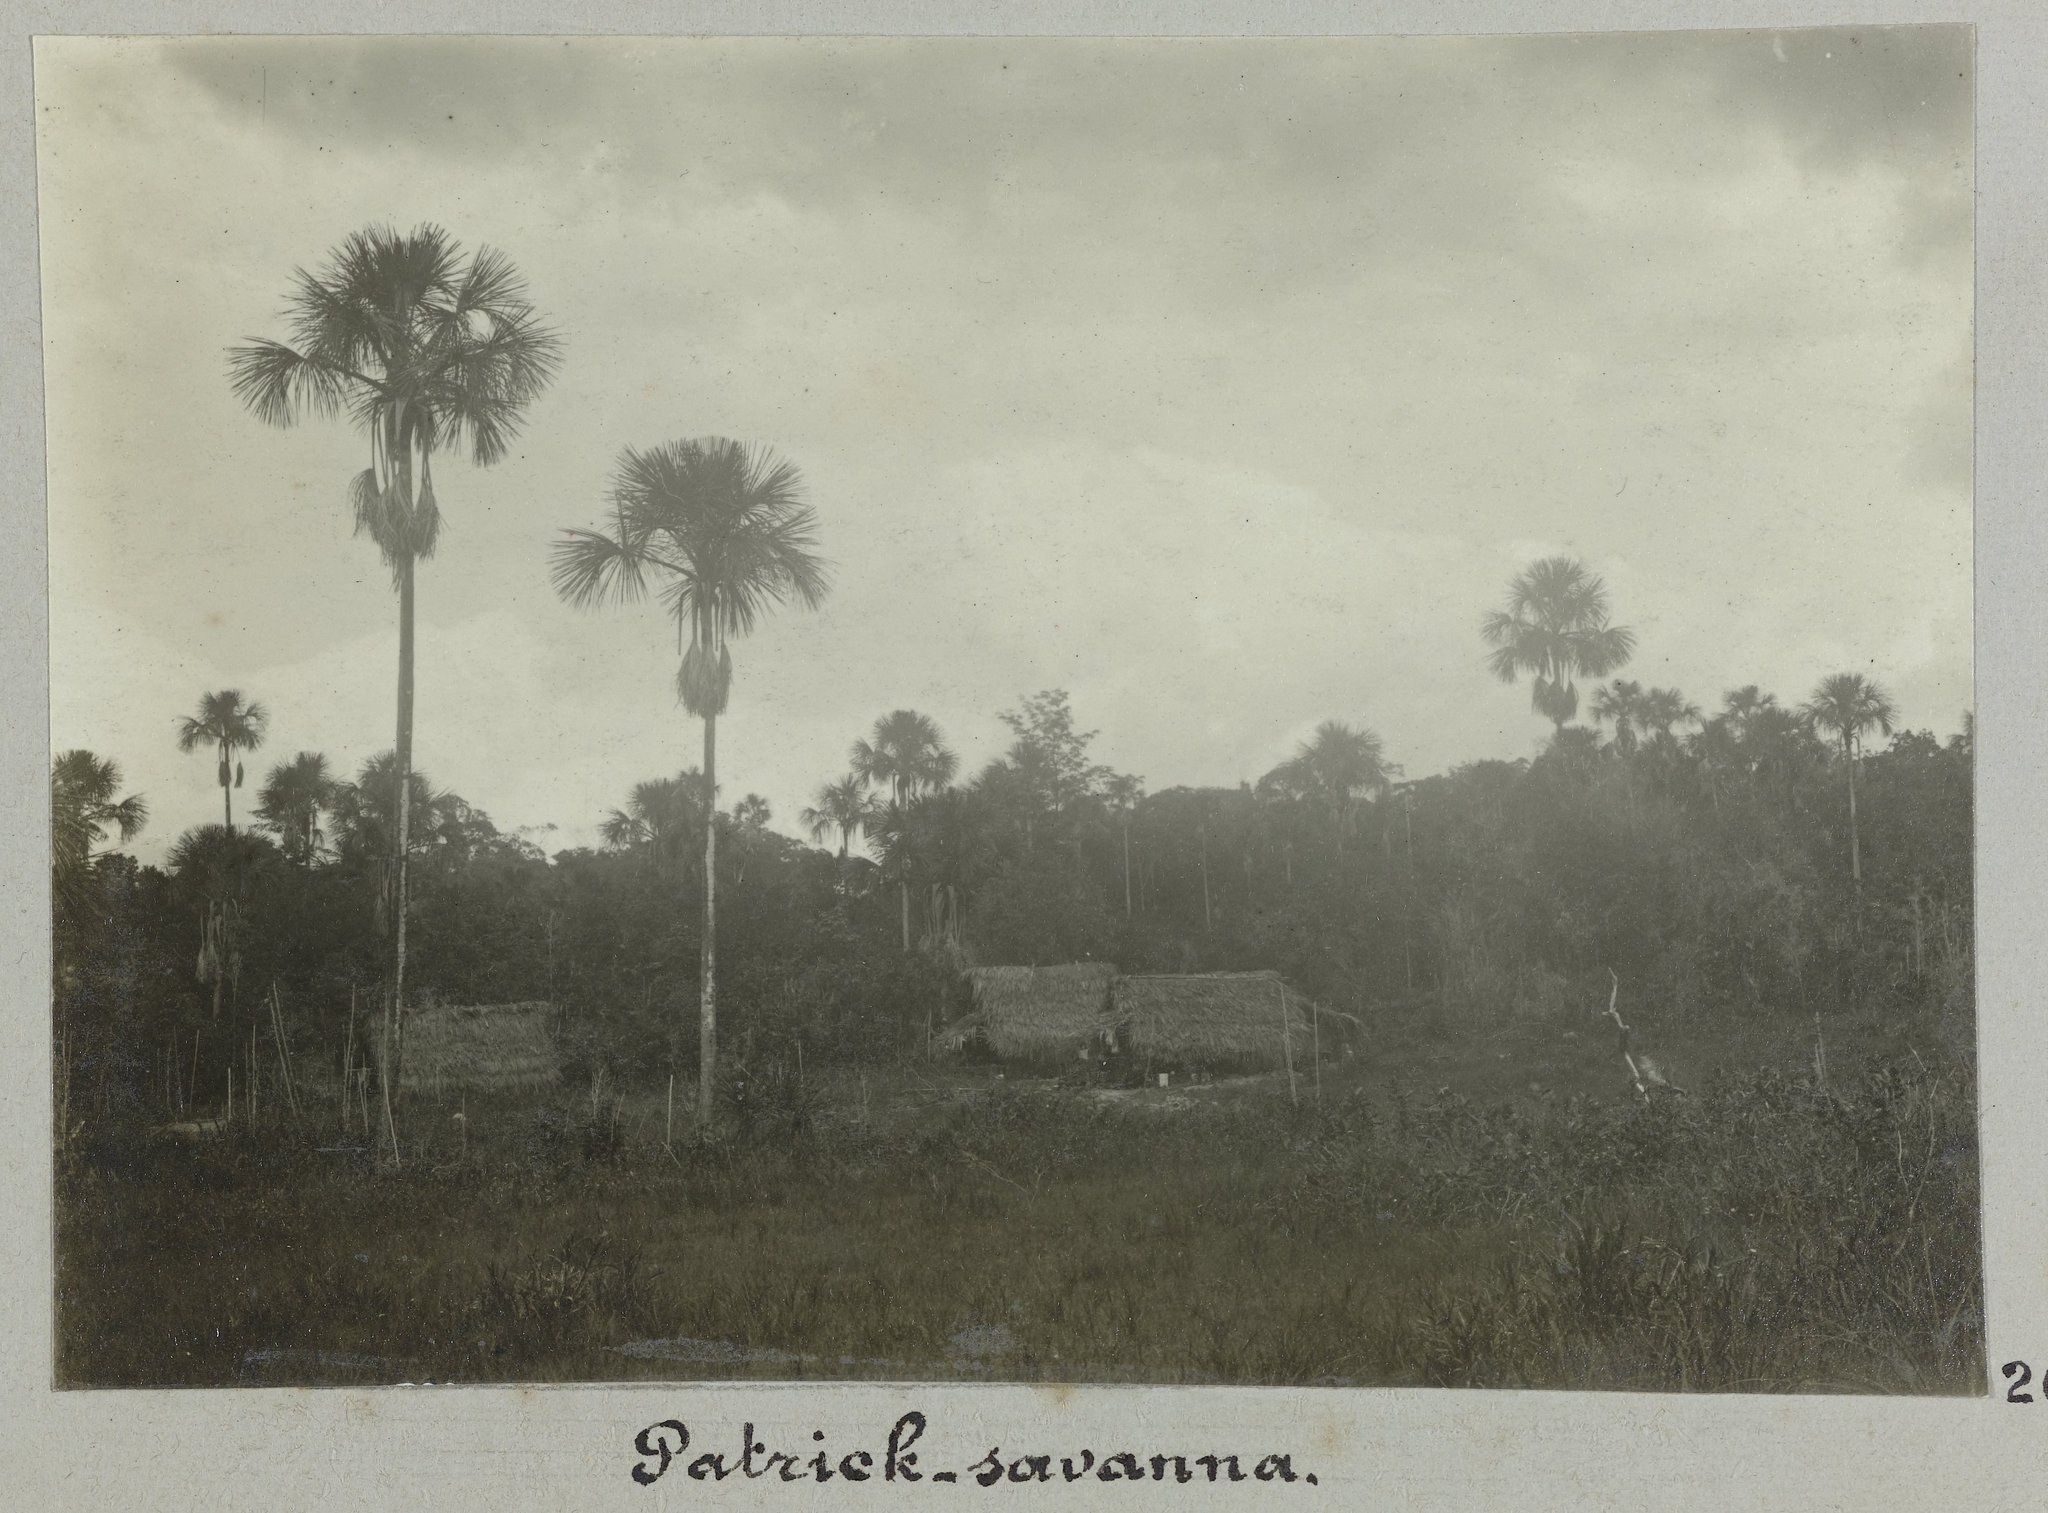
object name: photograph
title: Patrick-savanna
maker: hendrik doijer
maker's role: engineer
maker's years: 1863-1925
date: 1903-1910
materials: photographic support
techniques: gelatin silver print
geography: suriname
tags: suriname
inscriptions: inscription: ‘26. / Patrick-savanna.’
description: Verschillende huizen aan de rand van het bos, volgens het onderschrift betreft het de Patrick-savanna. Onderdeel van het fotoalbum Souvenir de Voyage (deel 1), over het leven van de familie Doijer in en rond de plantage Ma Retraite in Suriname in de jaren 1903-1910.